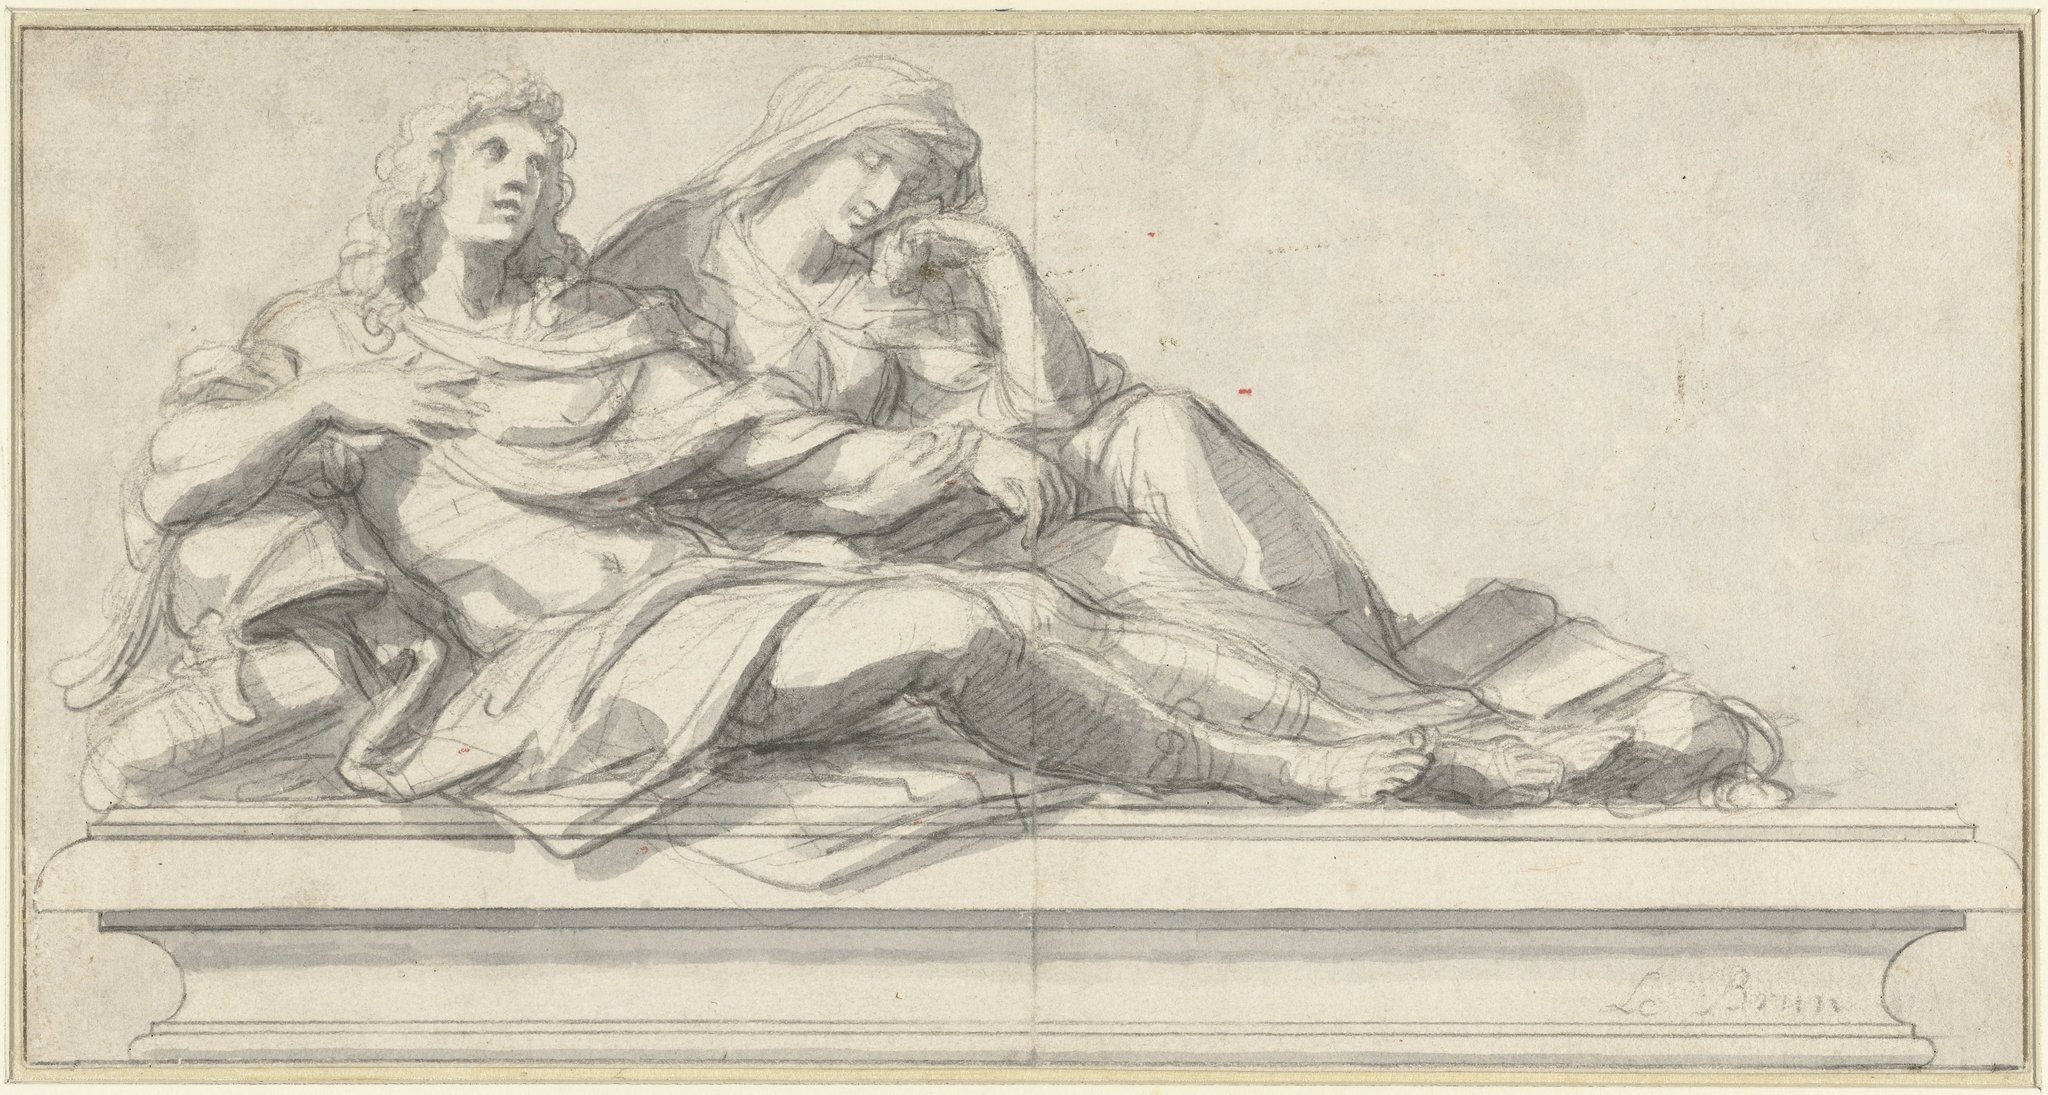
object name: design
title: Sarcofaag met daarop twee figuren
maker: charles le brun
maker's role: draughtsman, print maker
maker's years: 1619-1690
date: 1630-1690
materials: chalk, paper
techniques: brush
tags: lid of sarcophagus, grave-building, monumental tomb